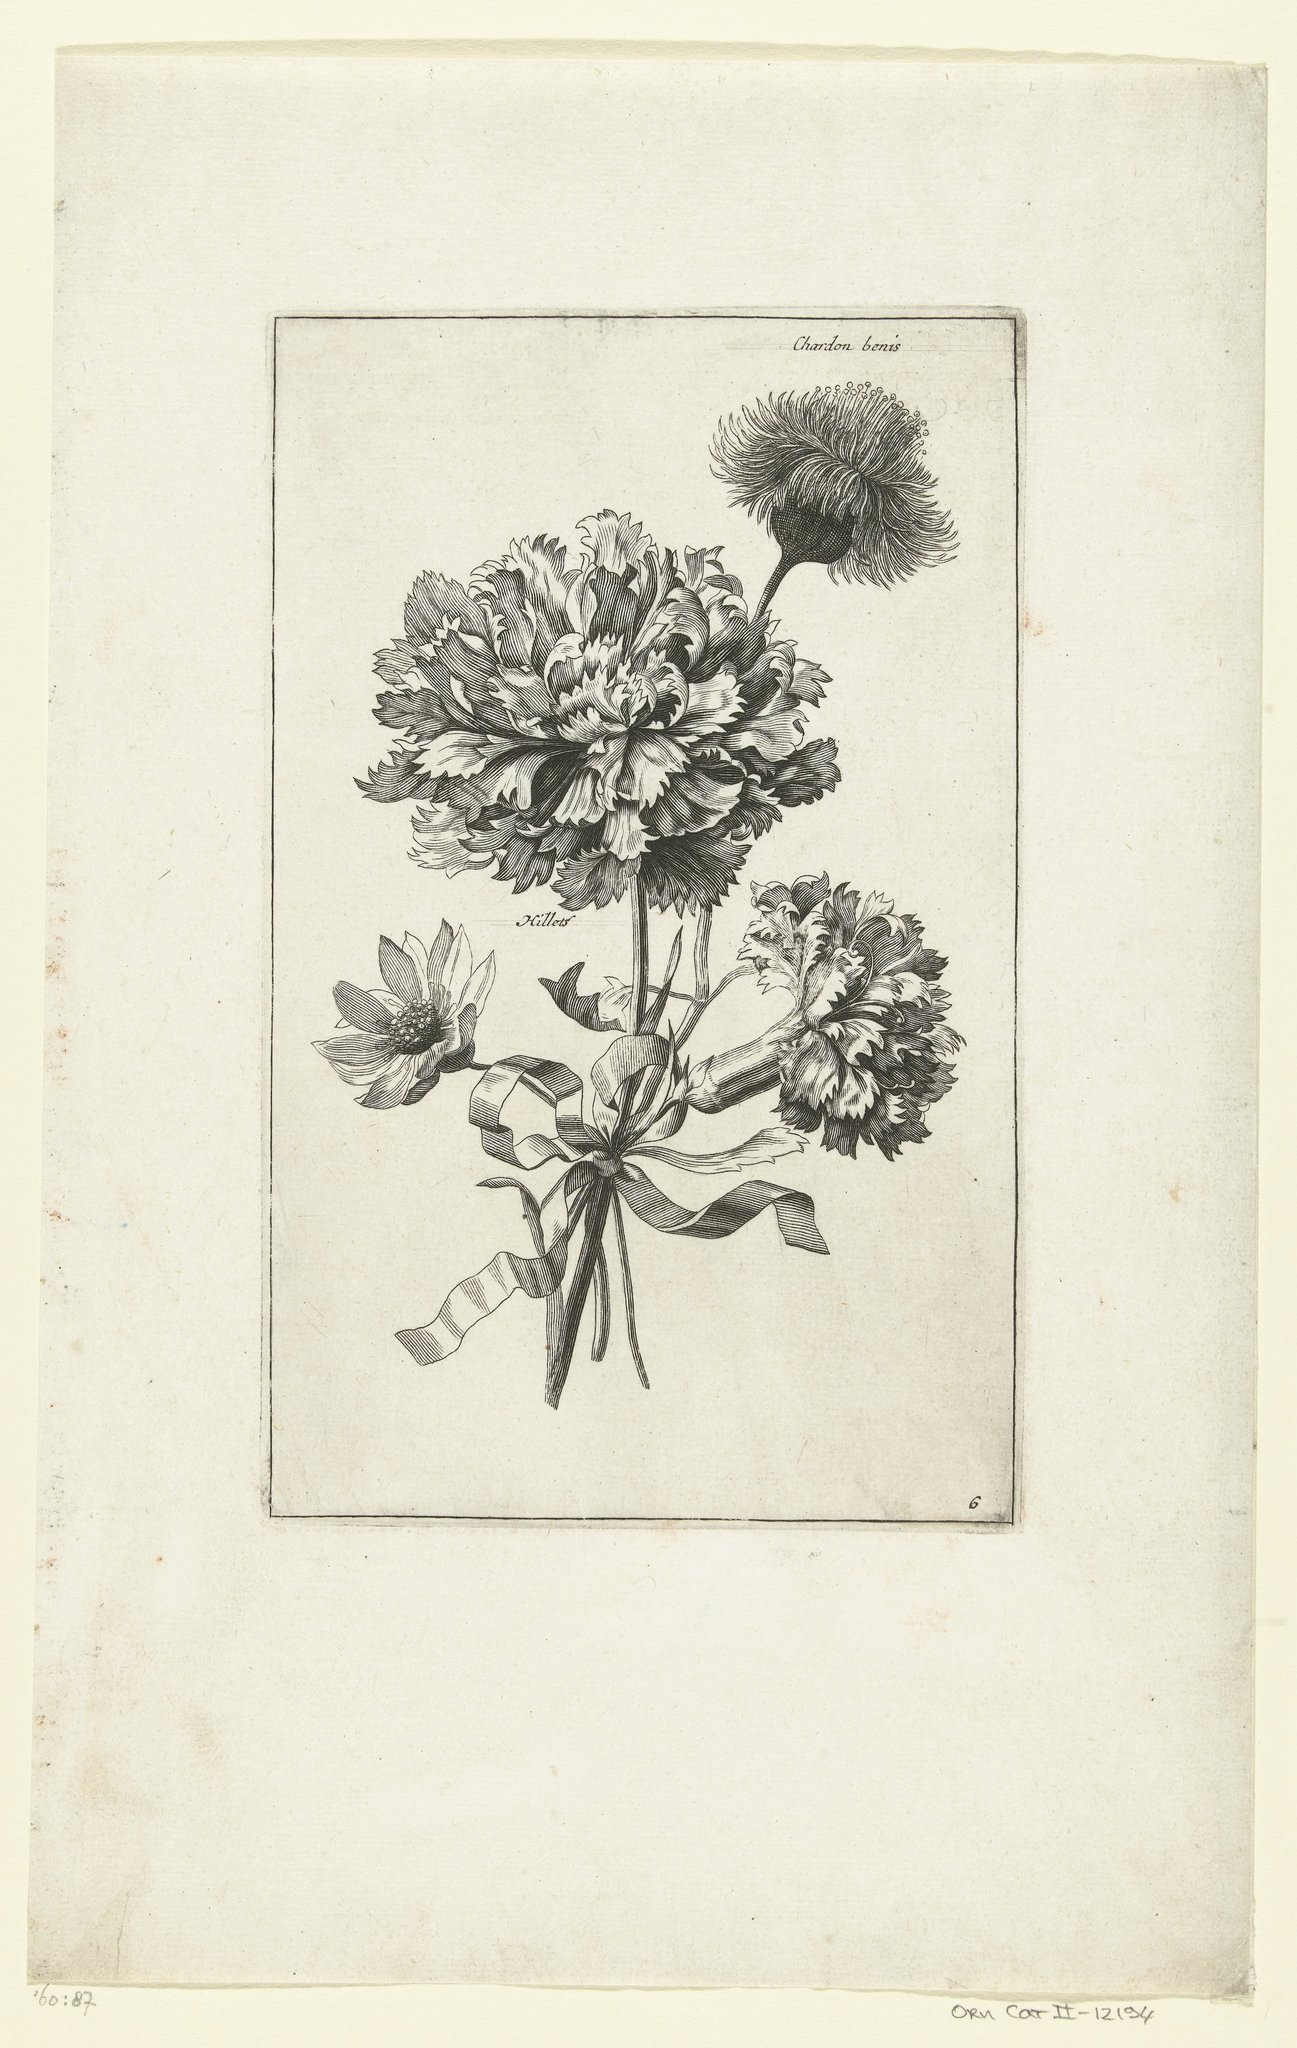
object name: ornament print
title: Bloemen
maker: Anonymous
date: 1700-1800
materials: paper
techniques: engraving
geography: netherlands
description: De bloemen zijn samengebonden in een boeket, met daarbij de namen.